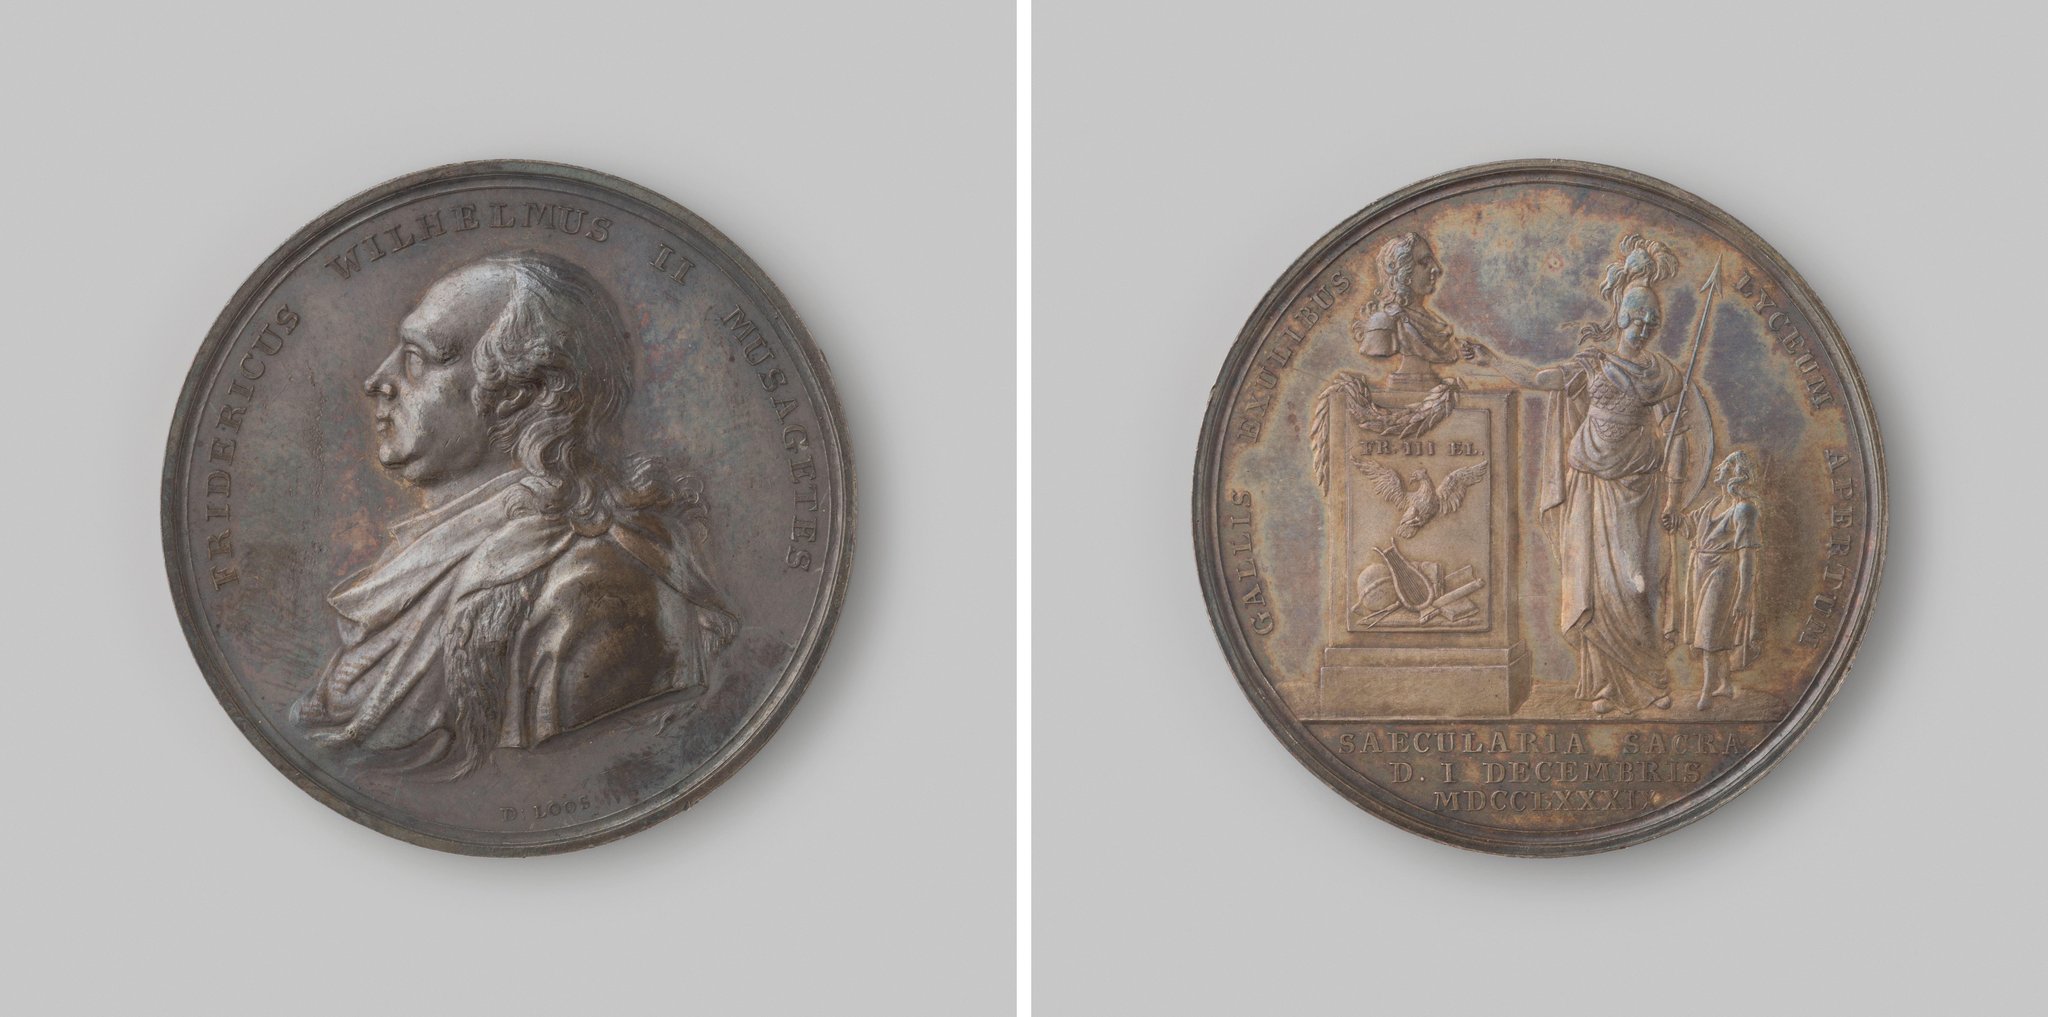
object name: history medal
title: Honderdjarig bestaan van het Franse Gymnasium te Berlijn 1789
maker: daniel friedrich loos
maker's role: medailleur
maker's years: 1735-1819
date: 1789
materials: silver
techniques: striking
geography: berlin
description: Zilveren penning, op de voorzijde het borstbeeld van Frederik Willem II van Pruisen met omschrift, op de keerzijde Minerva die een leerling wijst op het borstbeeld van Frederik III op een gelauwerd altaar, met omschrift en afsnedetekst.